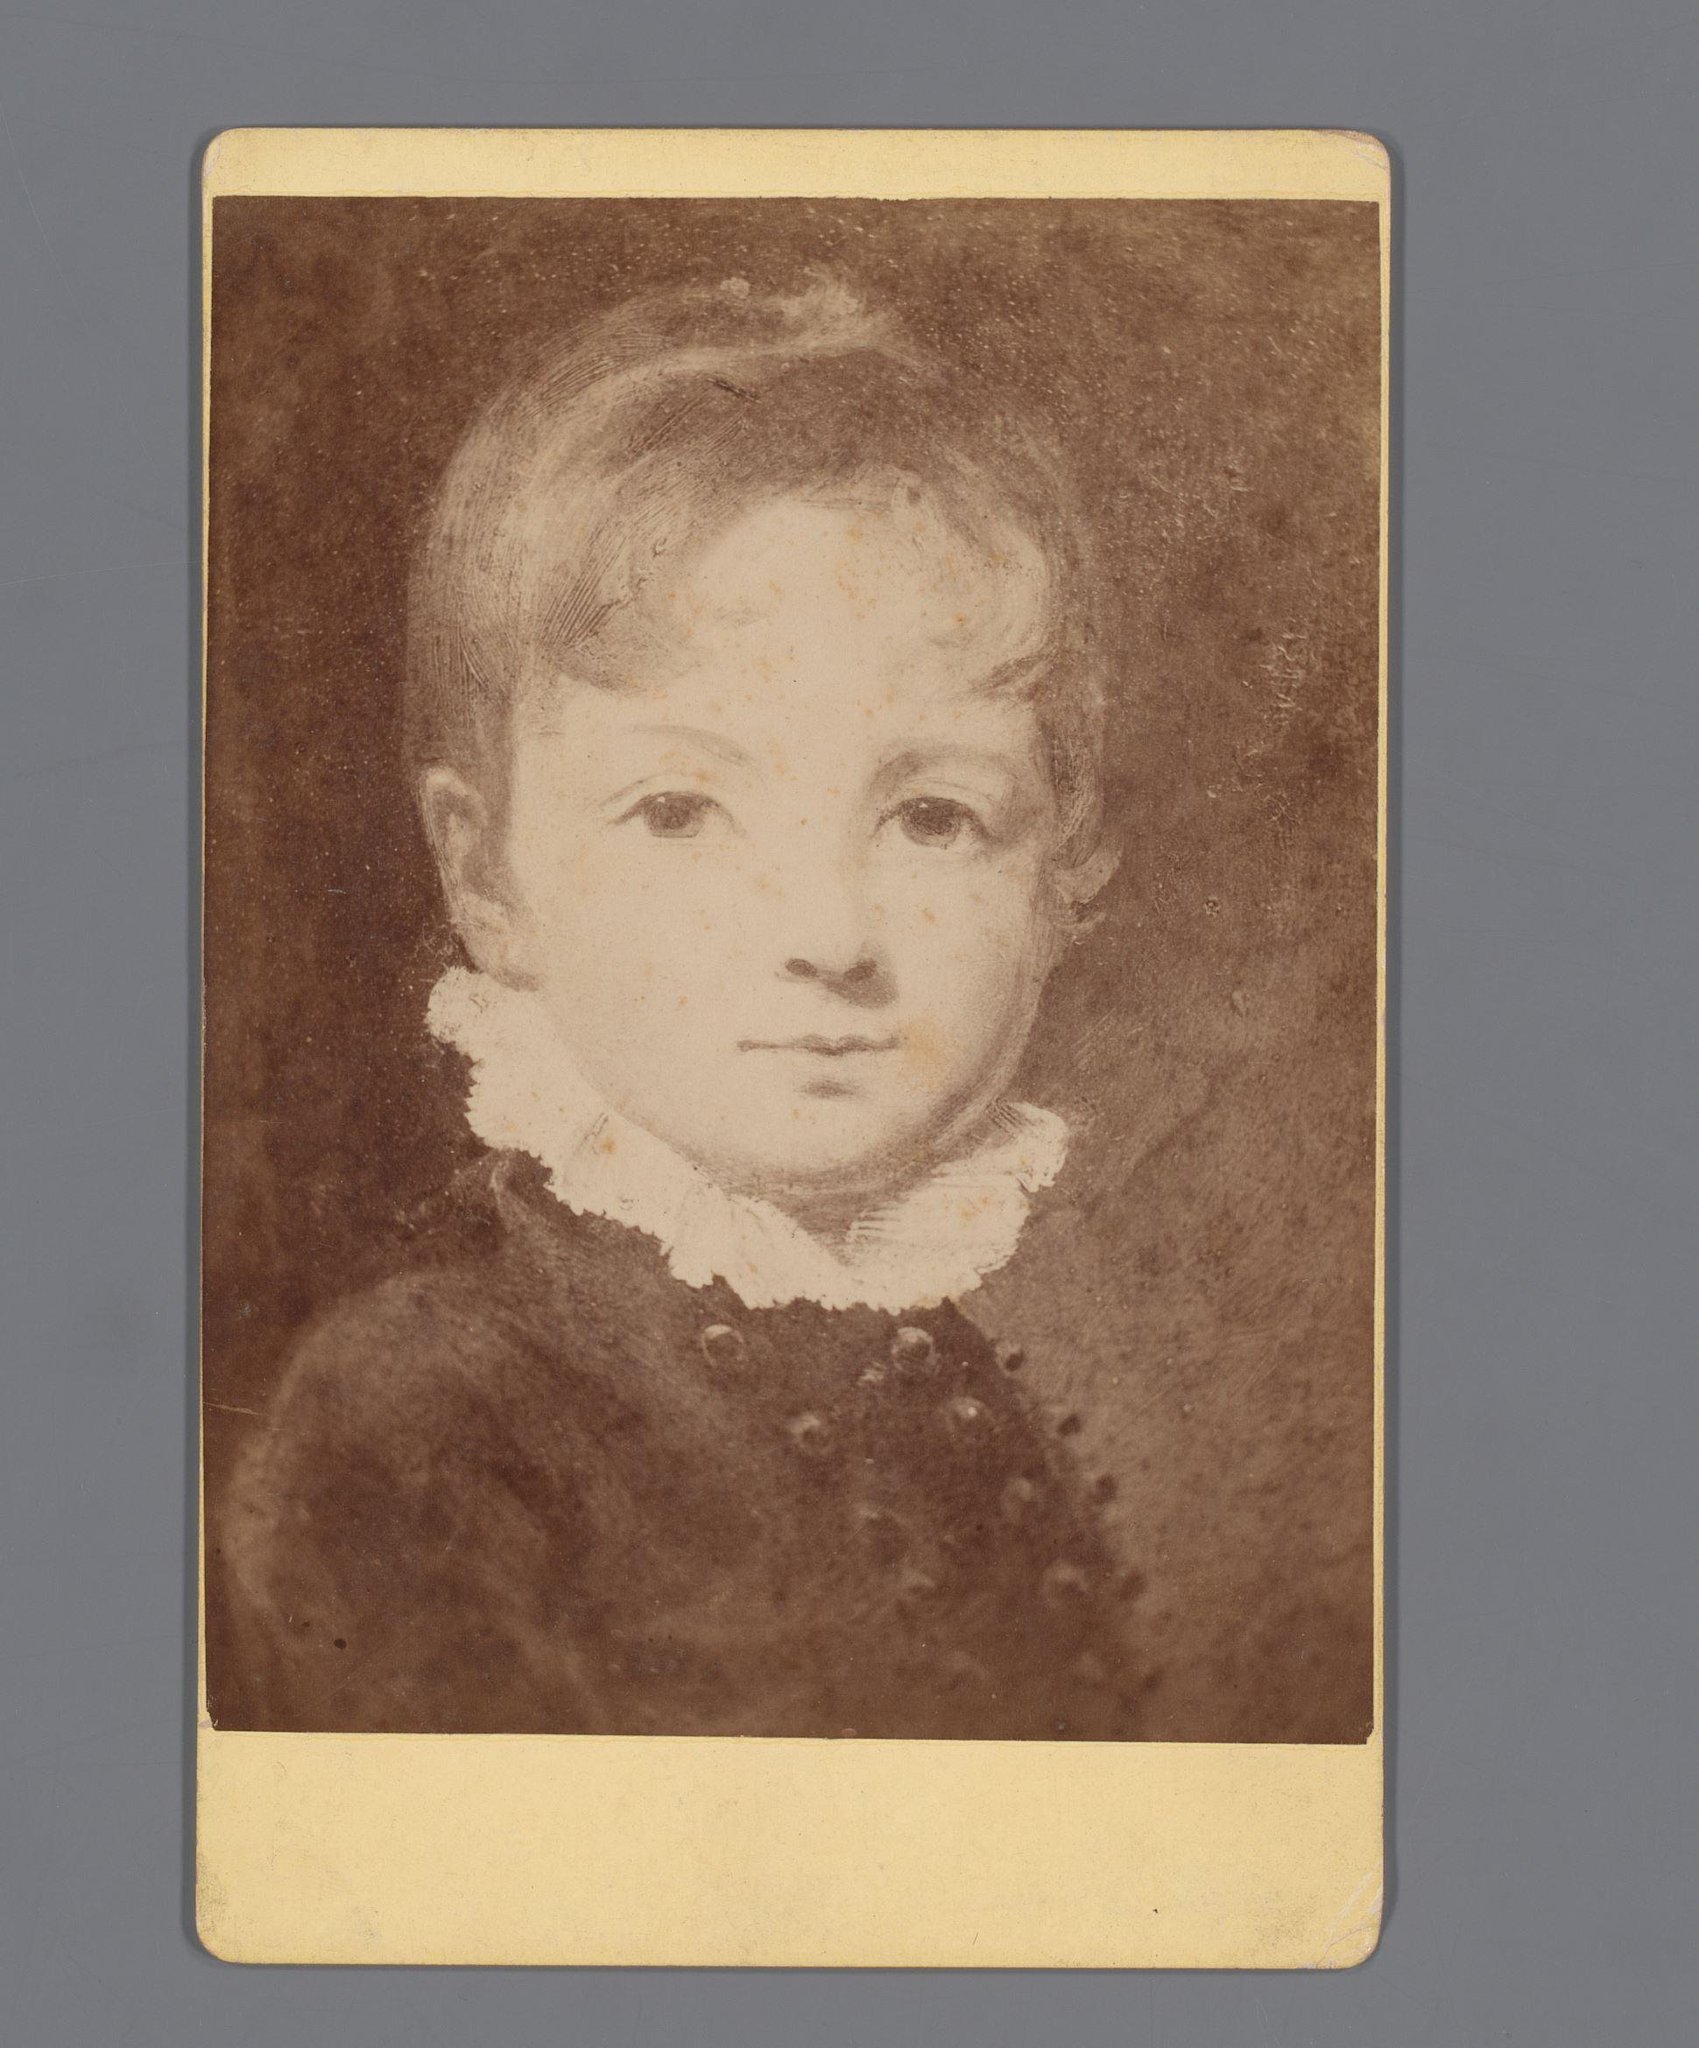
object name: reproduction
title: Fotoreproductie van een schilderij van een jongen (William Proctor)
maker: Anonymous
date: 1880-1900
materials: cardboard, paper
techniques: albumen print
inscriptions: inscription: ‘William Proctor//son of Forster Thomas Proctor// x Elizabeth his wife// father of William Addy Proctor’